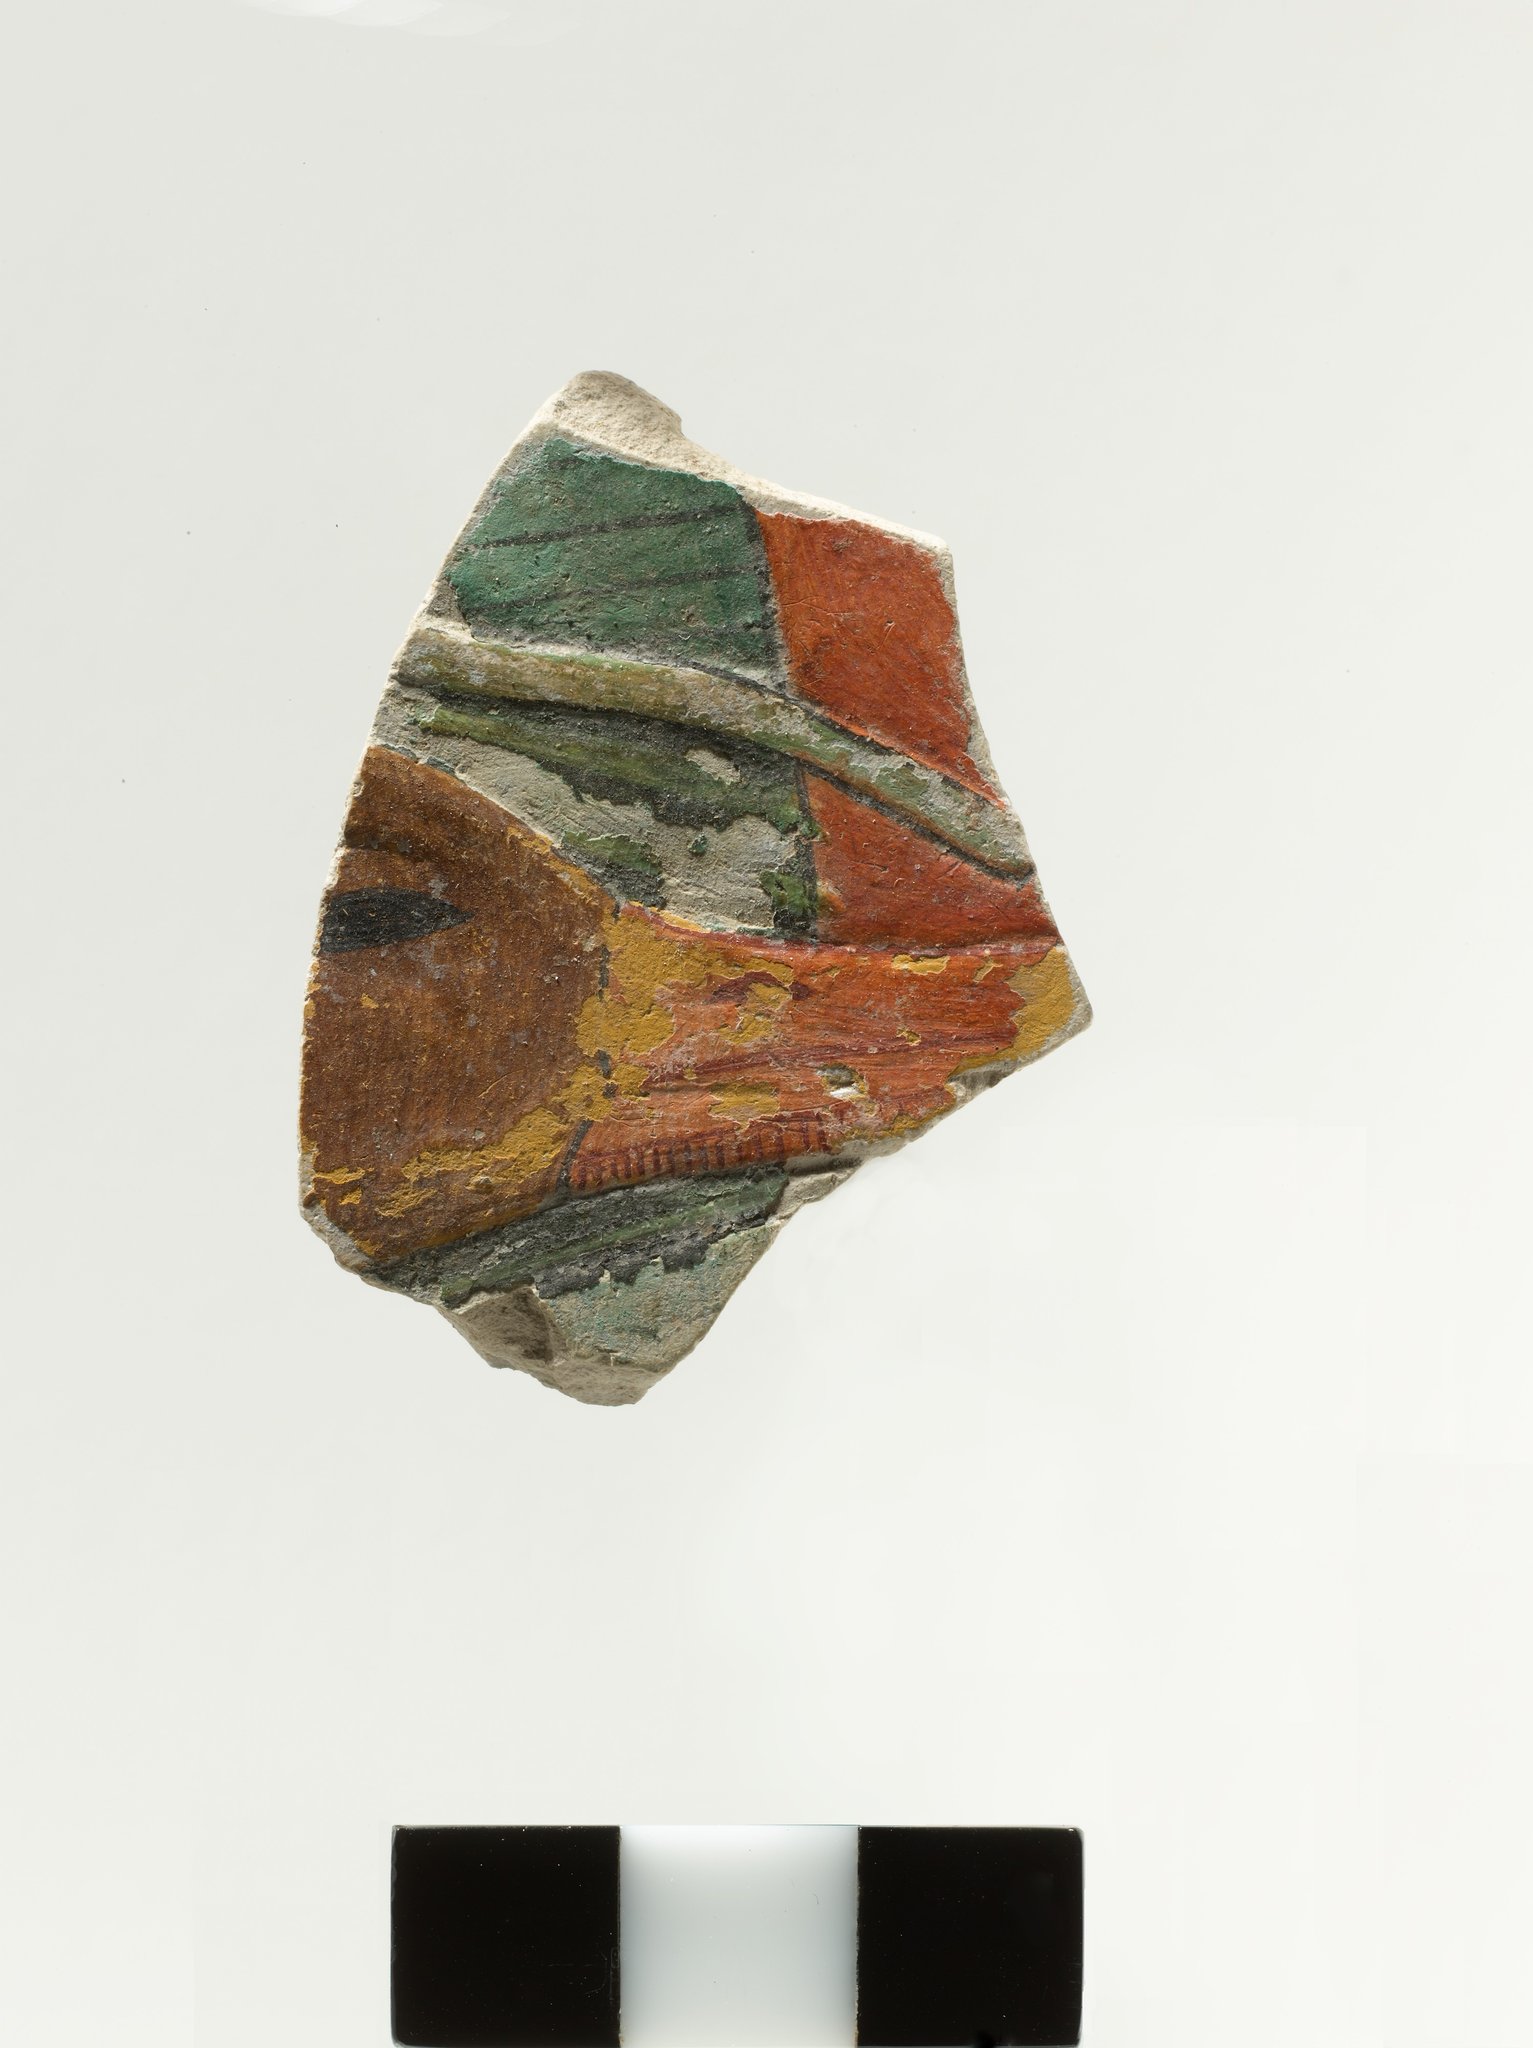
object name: relief fragment, tomb of meketre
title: Relief fragment from the tomb of Meketre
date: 1981-1975 BCE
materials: limestone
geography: egypt